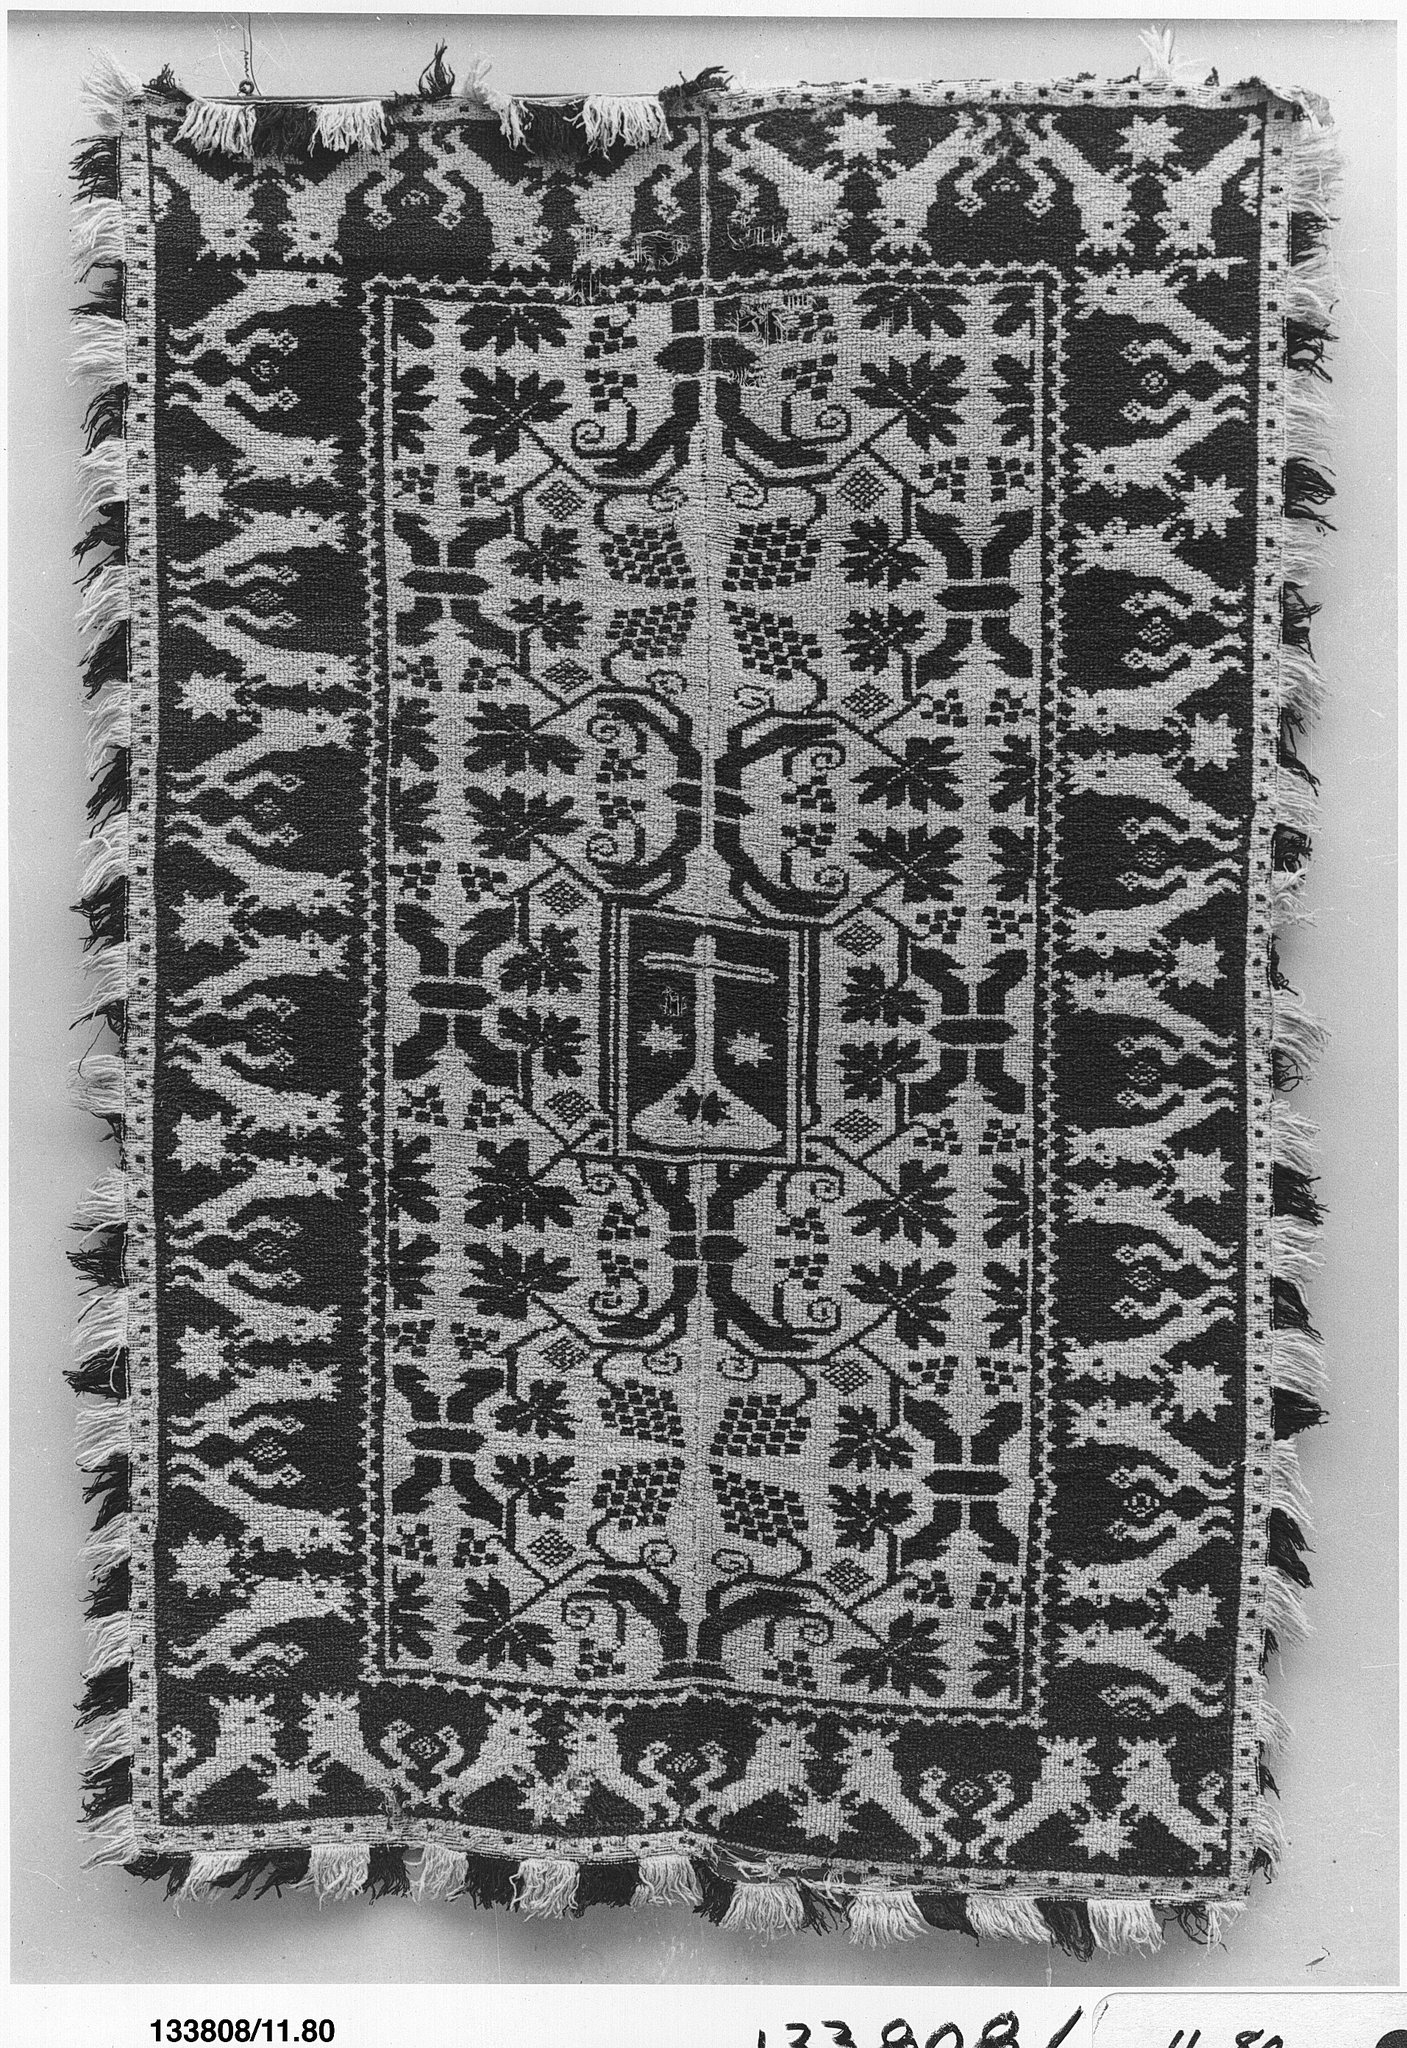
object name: rug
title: Rug with Carmelite Order coat-of-arms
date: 1701-1800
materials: cotton, wool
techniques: weave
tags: coat of arms